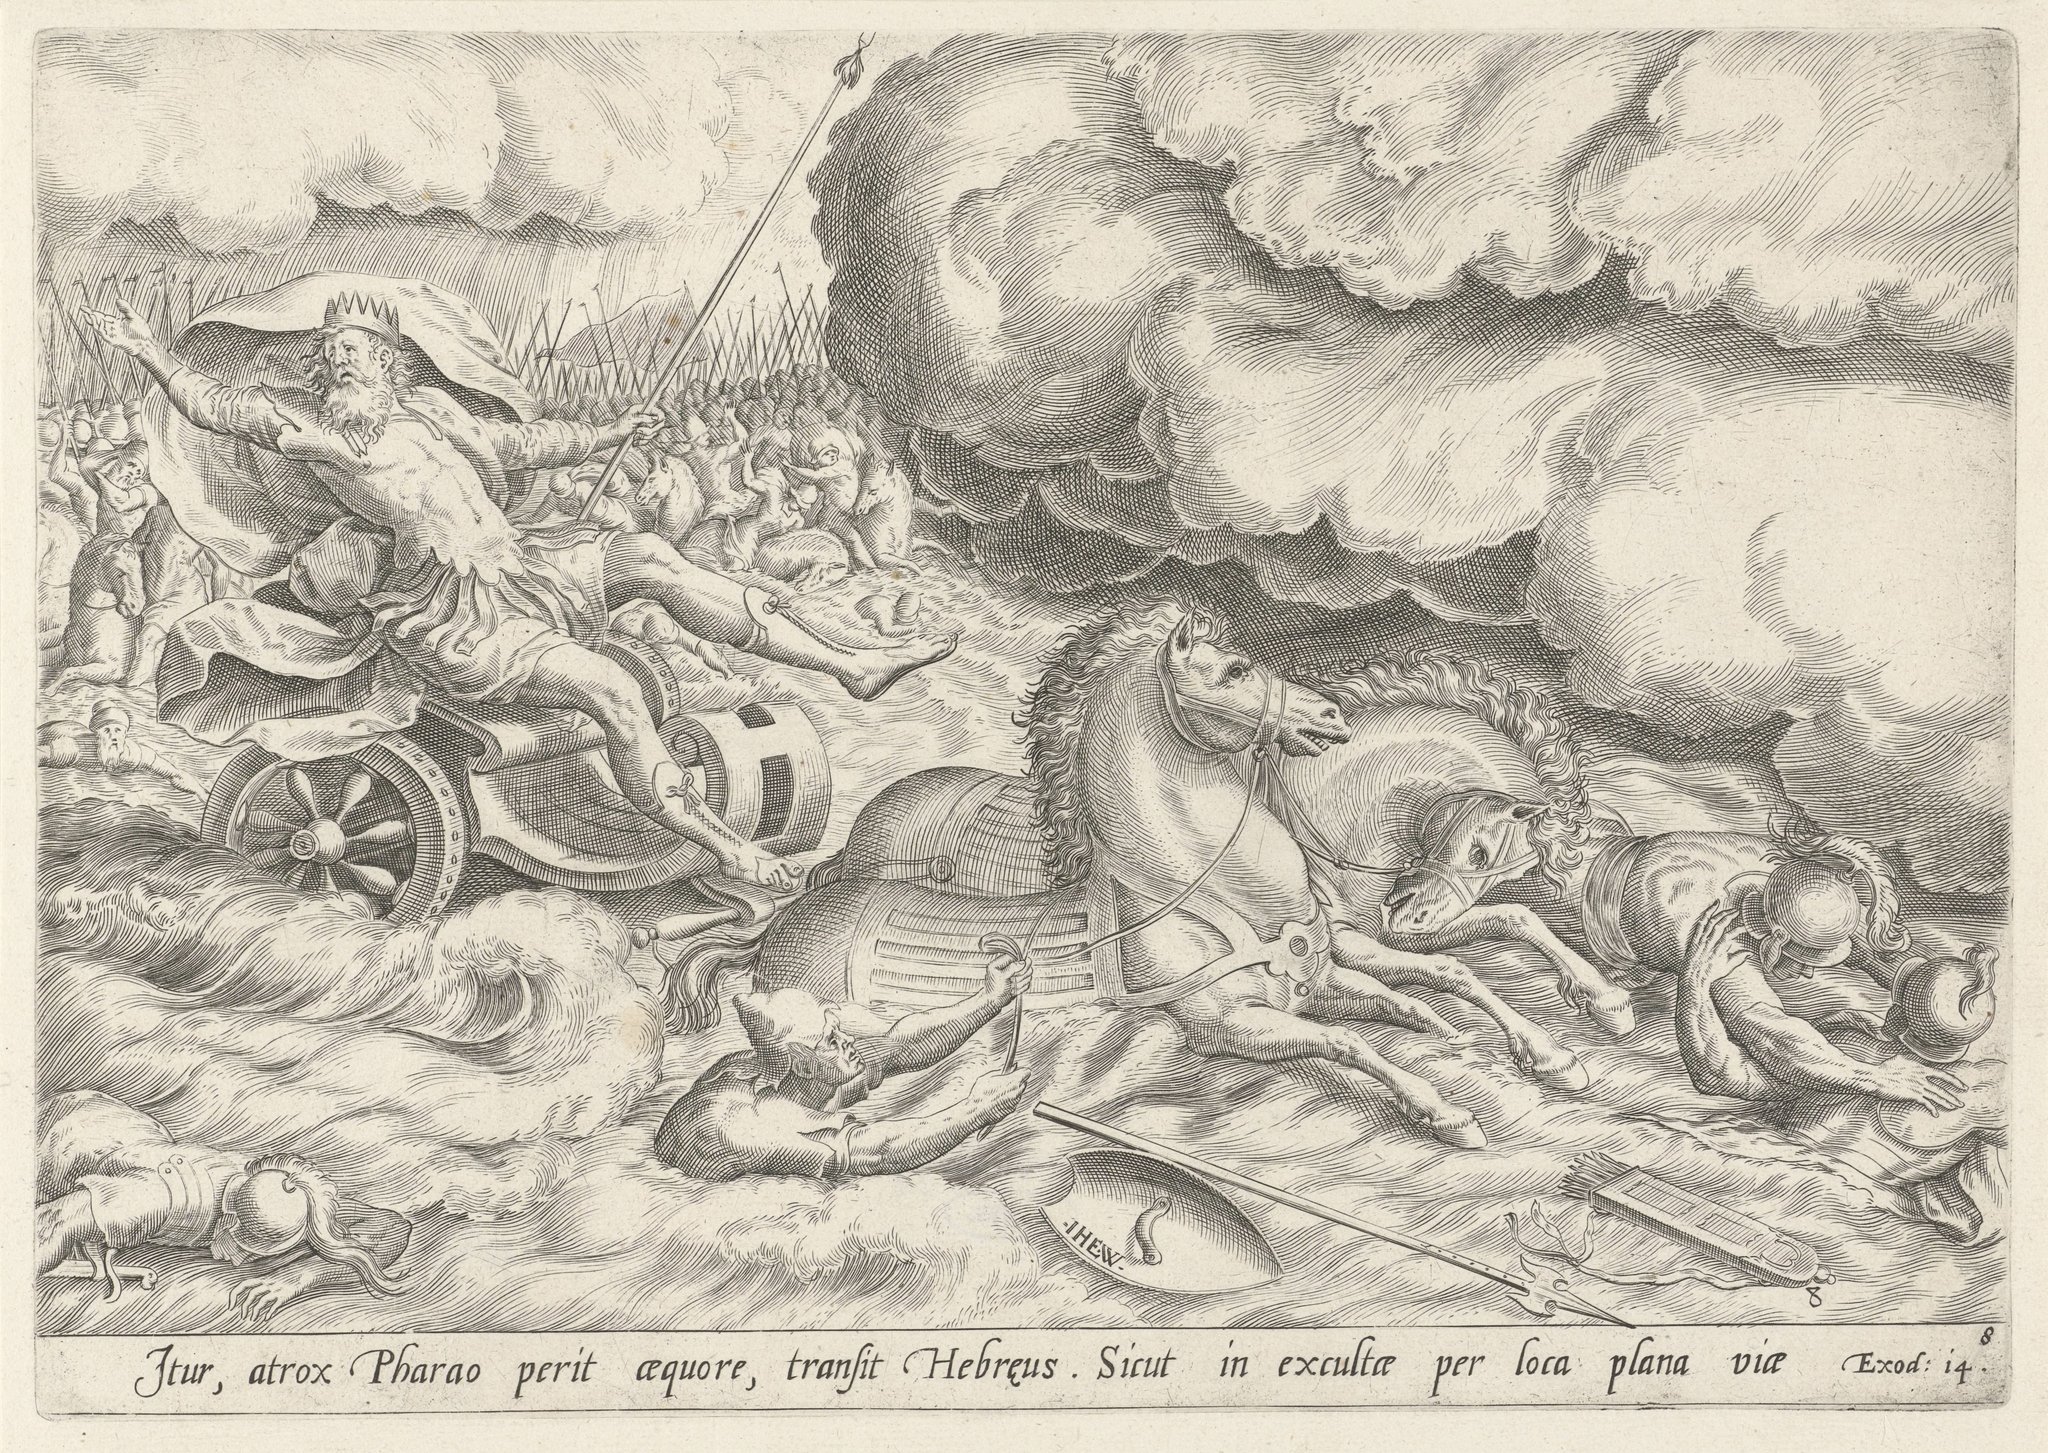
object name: print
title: Vernietiging van het Egyptische leger in de Rode Zee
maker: johannes wierix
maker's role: draughtsman, print maker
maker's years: 1549-1618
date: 1579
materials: paper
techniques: engraving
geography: antwerp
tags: pharaoh and his army engulfed in the red sea (israelites not or barely visible)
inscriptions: collector's mark: Lugt 2228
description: Terwijl het Egyptische leger de Rode Zee oversteekt, doet Mozes het water terugvloeien. De farao en de rest van het leger worden overspoeld en verdrinken. De prent heeft een Latijns onderschrift.